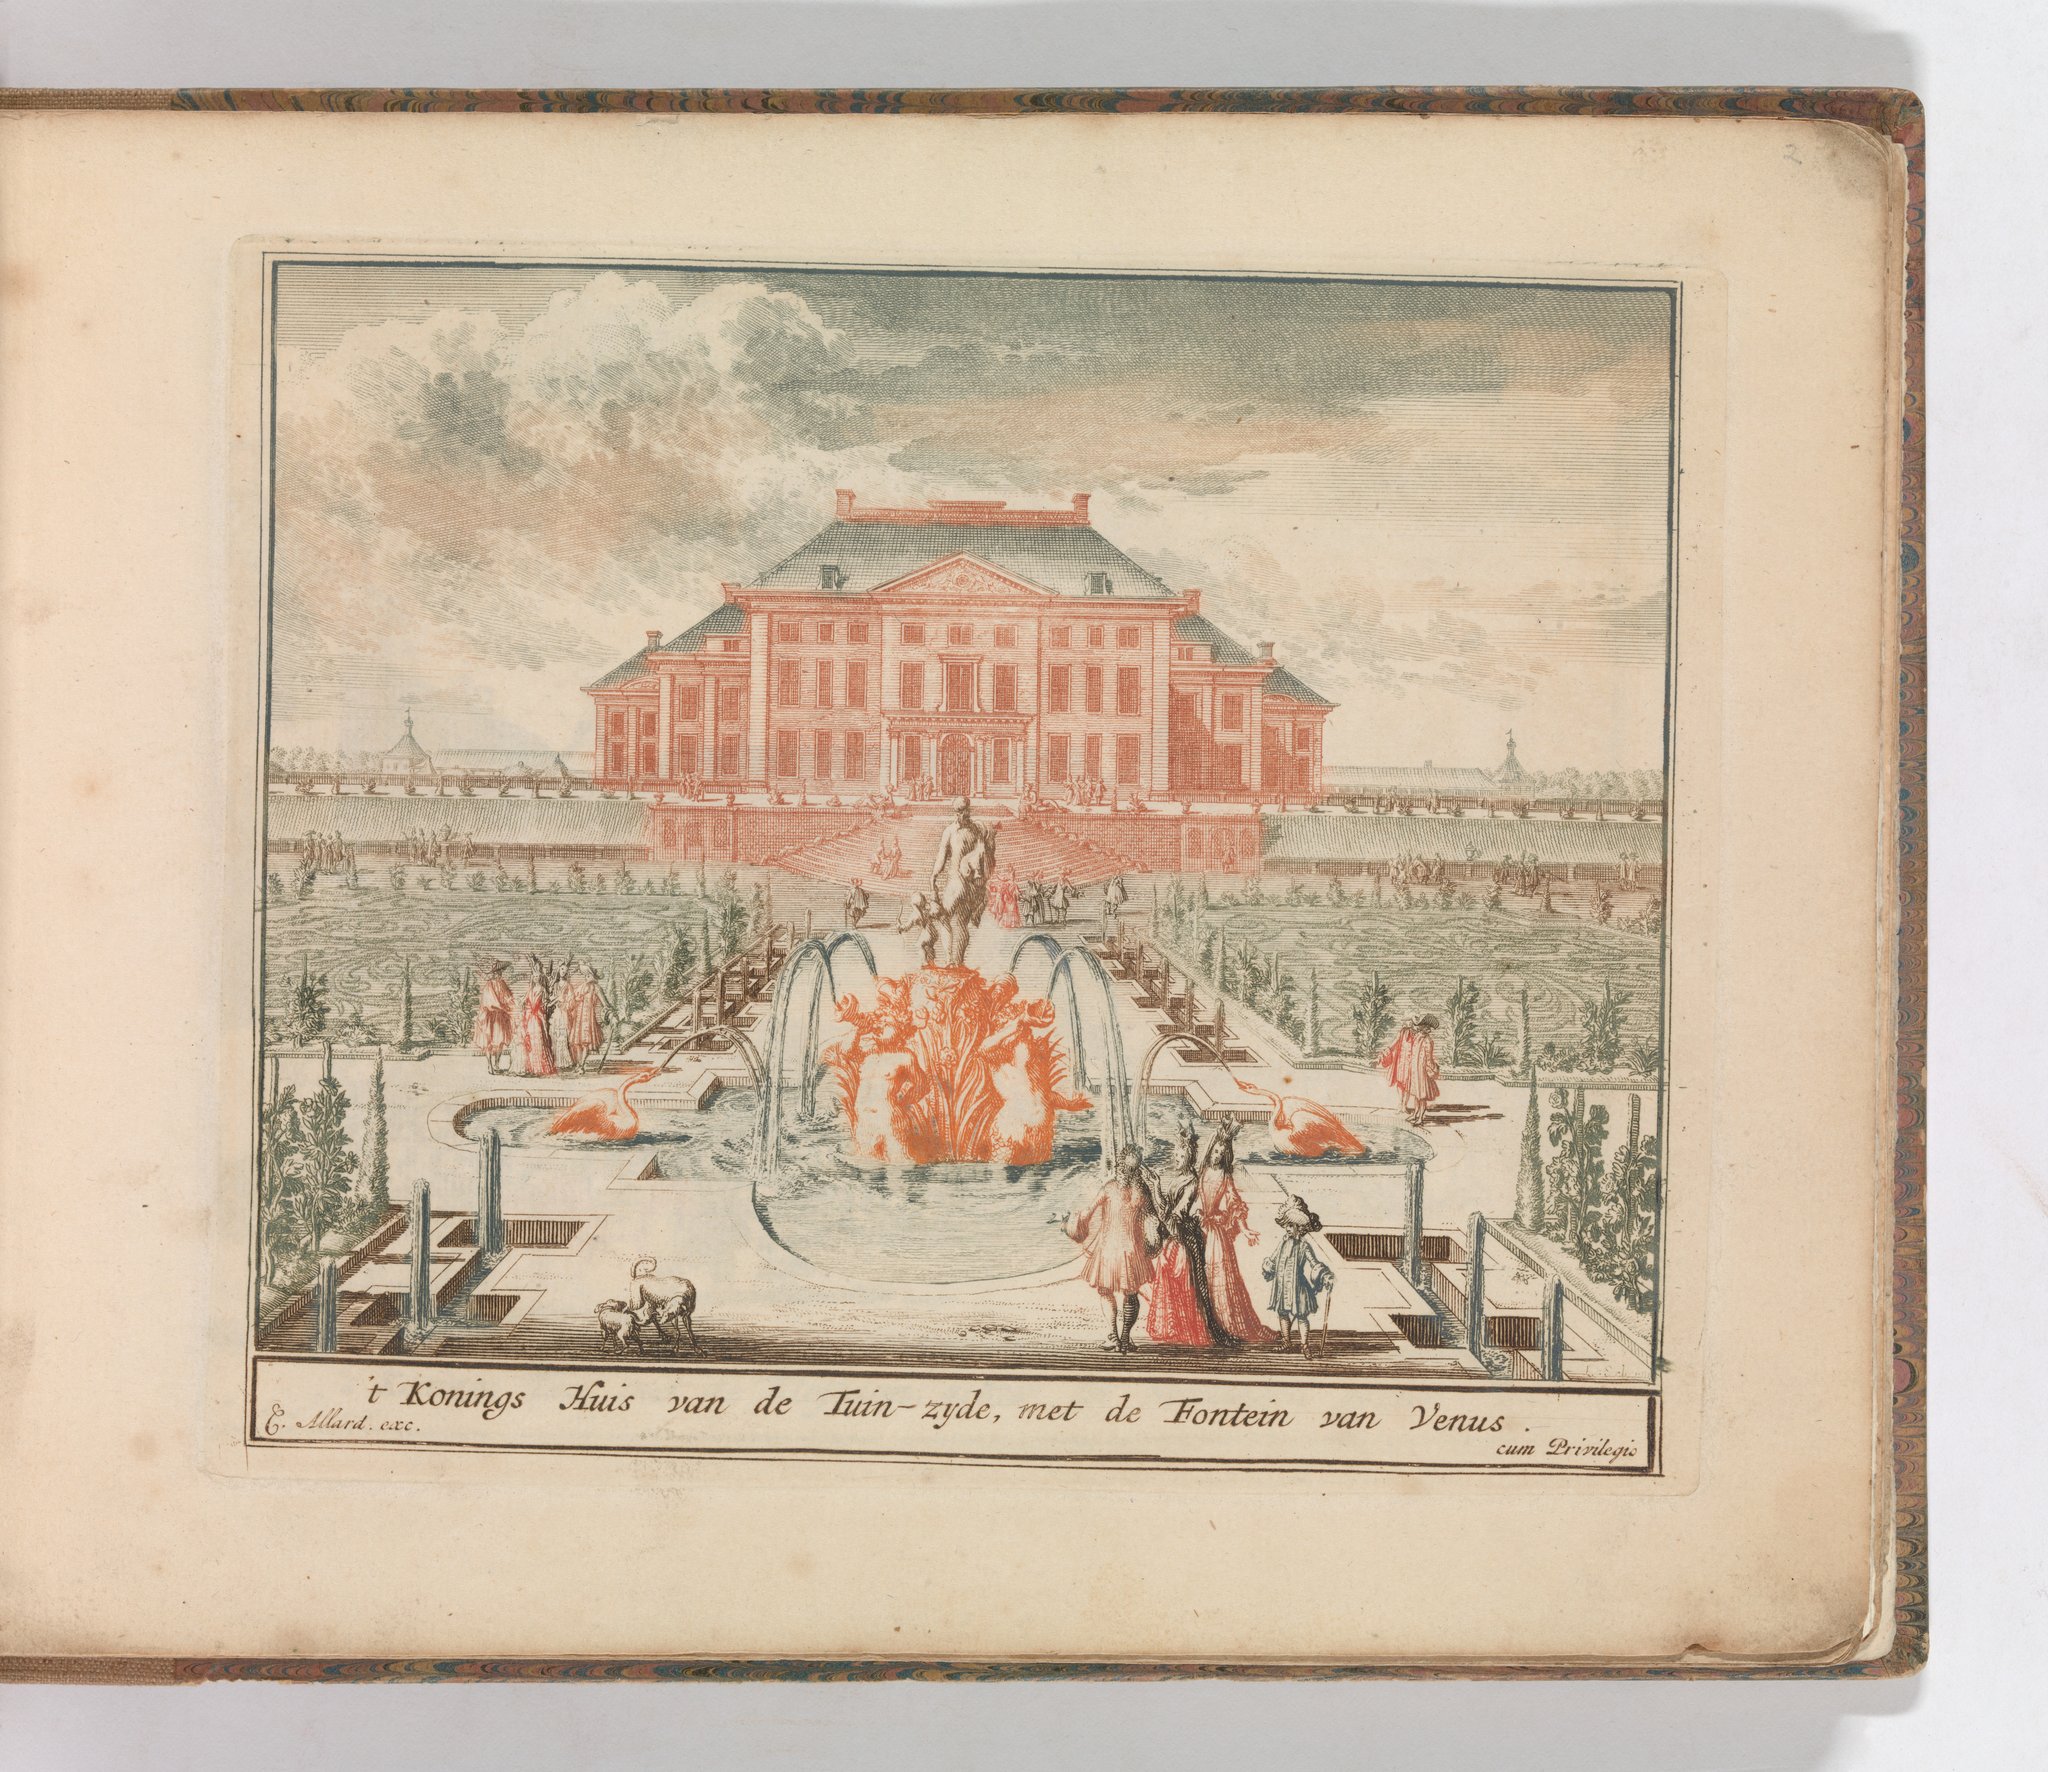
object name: book print ornament architecture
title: " ’t Konings Huis van de Tuin-zyde, met de Fontein van Venus", in: Tooneel Der Voornaamste Nederlands Huizen, En Lust Hoven, Naar T Leven Afgebeeld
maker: carel allard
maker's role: publisher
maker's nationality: dutch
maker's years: 1648-1709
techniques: engraving, lithography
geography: amsterdam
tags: birds,buildings,fountains,men,women